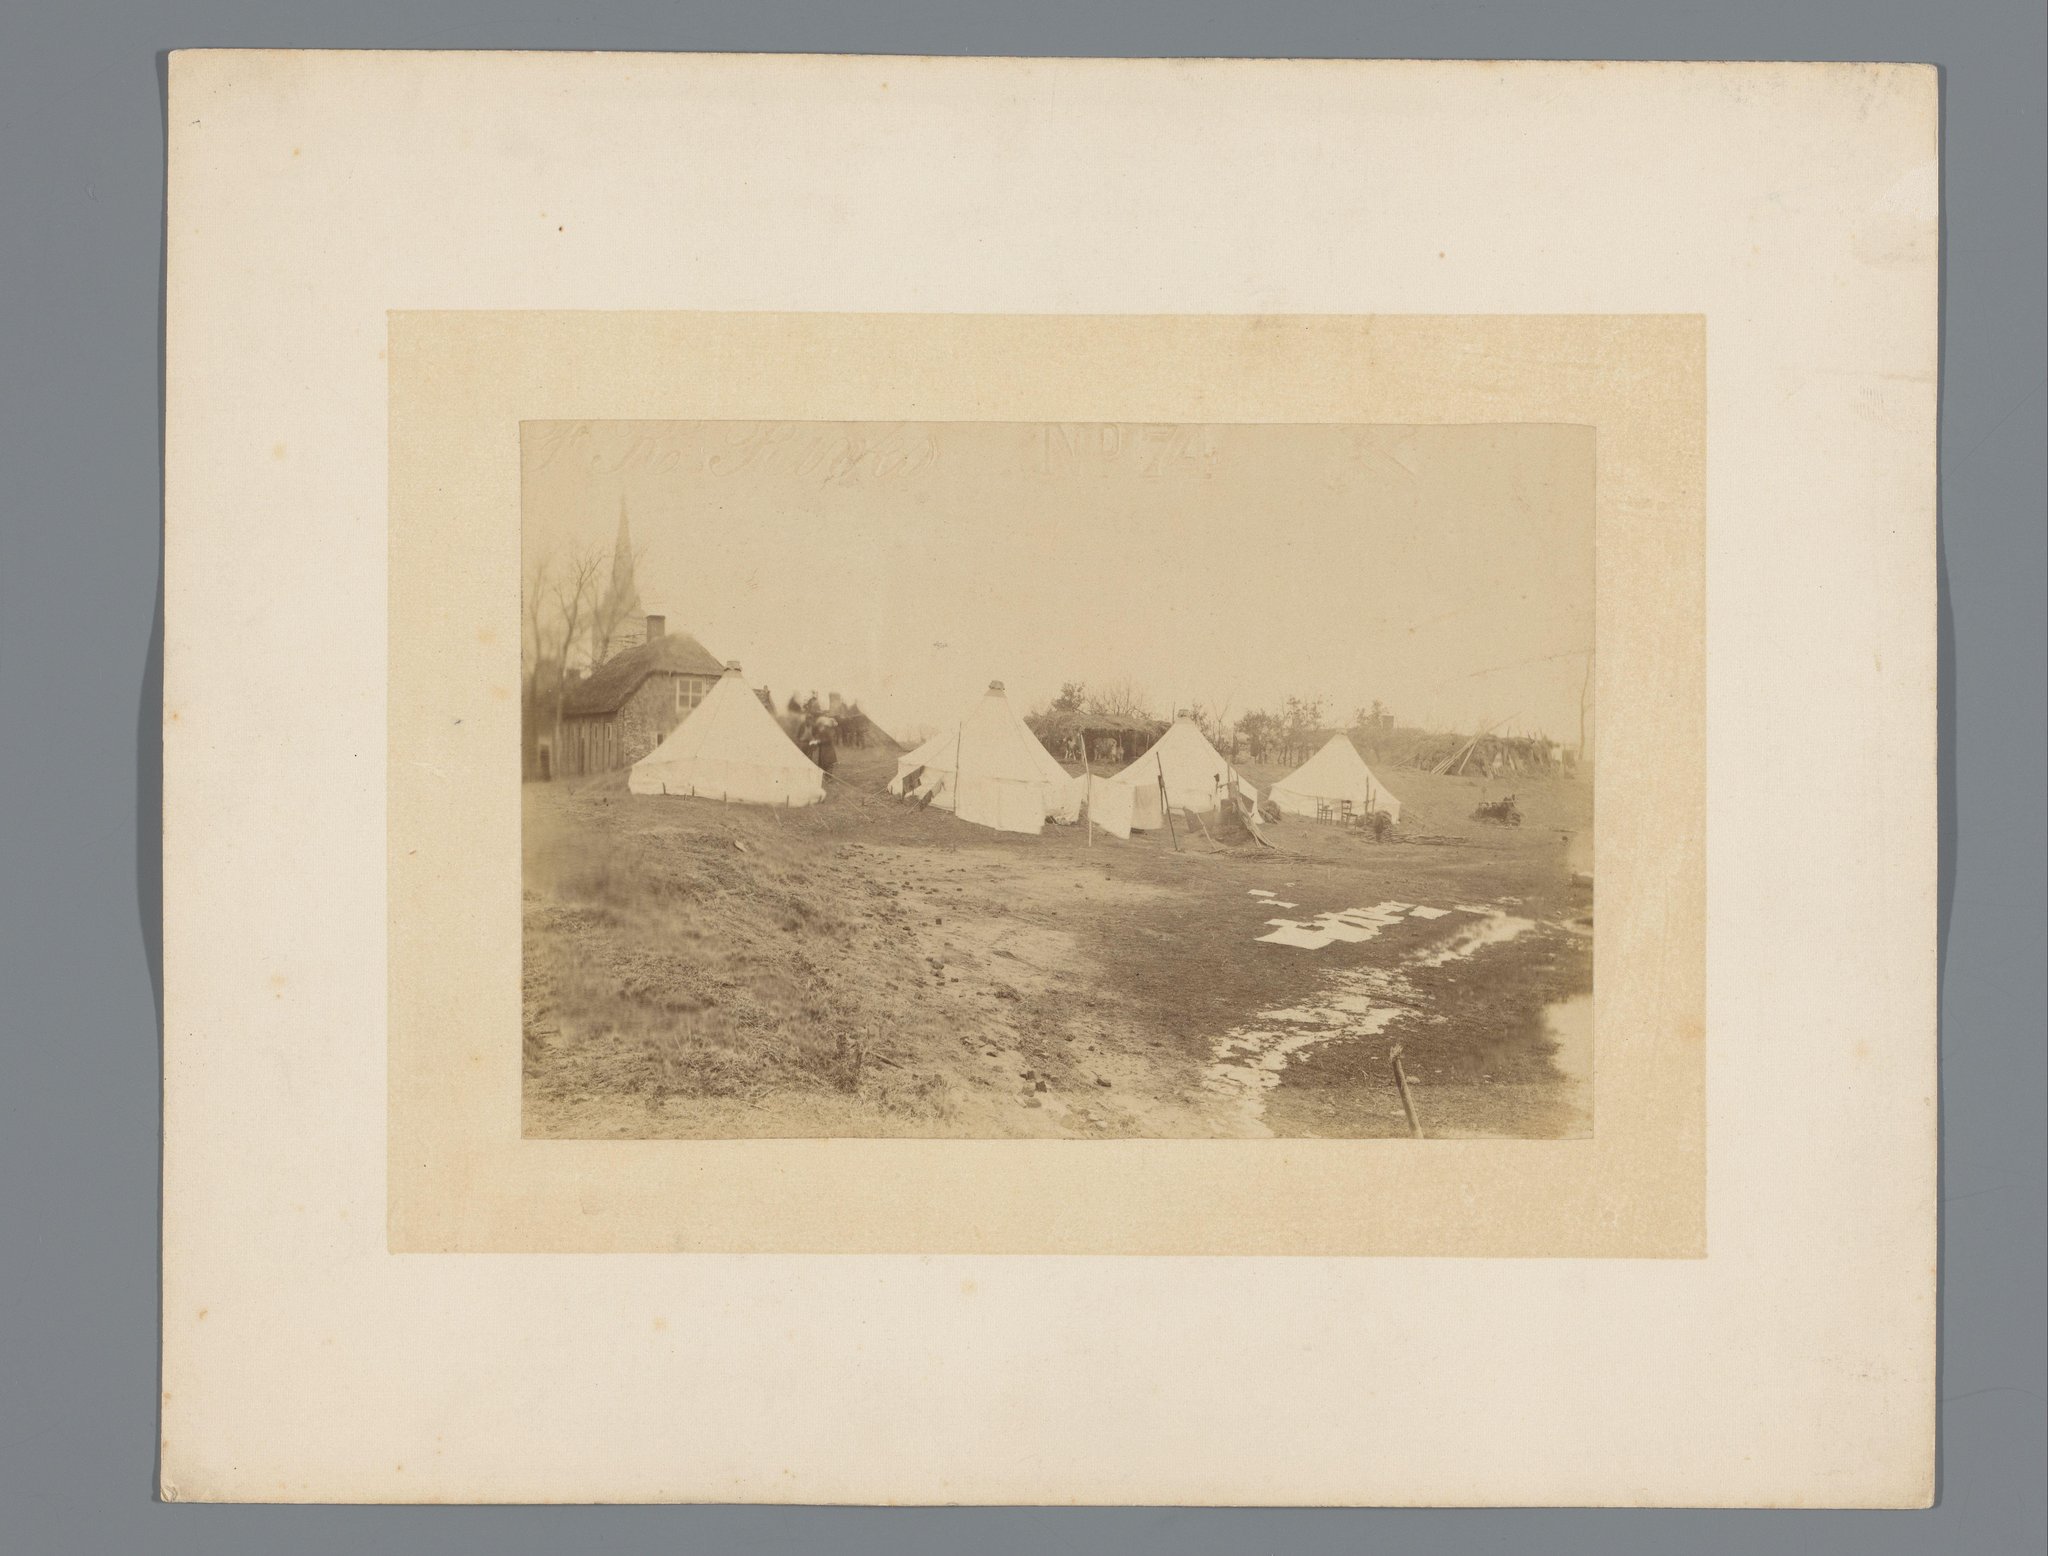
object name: photograph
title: Overstroming in Nieuwkuijk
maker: albert greiner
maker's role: fotograaf, fotostudio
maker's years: 1833-1890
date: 1880-1881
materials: paper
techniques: albumen print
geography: amsterdam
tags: village, flood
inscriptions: annotation: ‘Overstrooming Nieuwkuyk, 1916’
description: de overstroming in Nieuwkuyk vond plaats in 1880 en niet in 1916